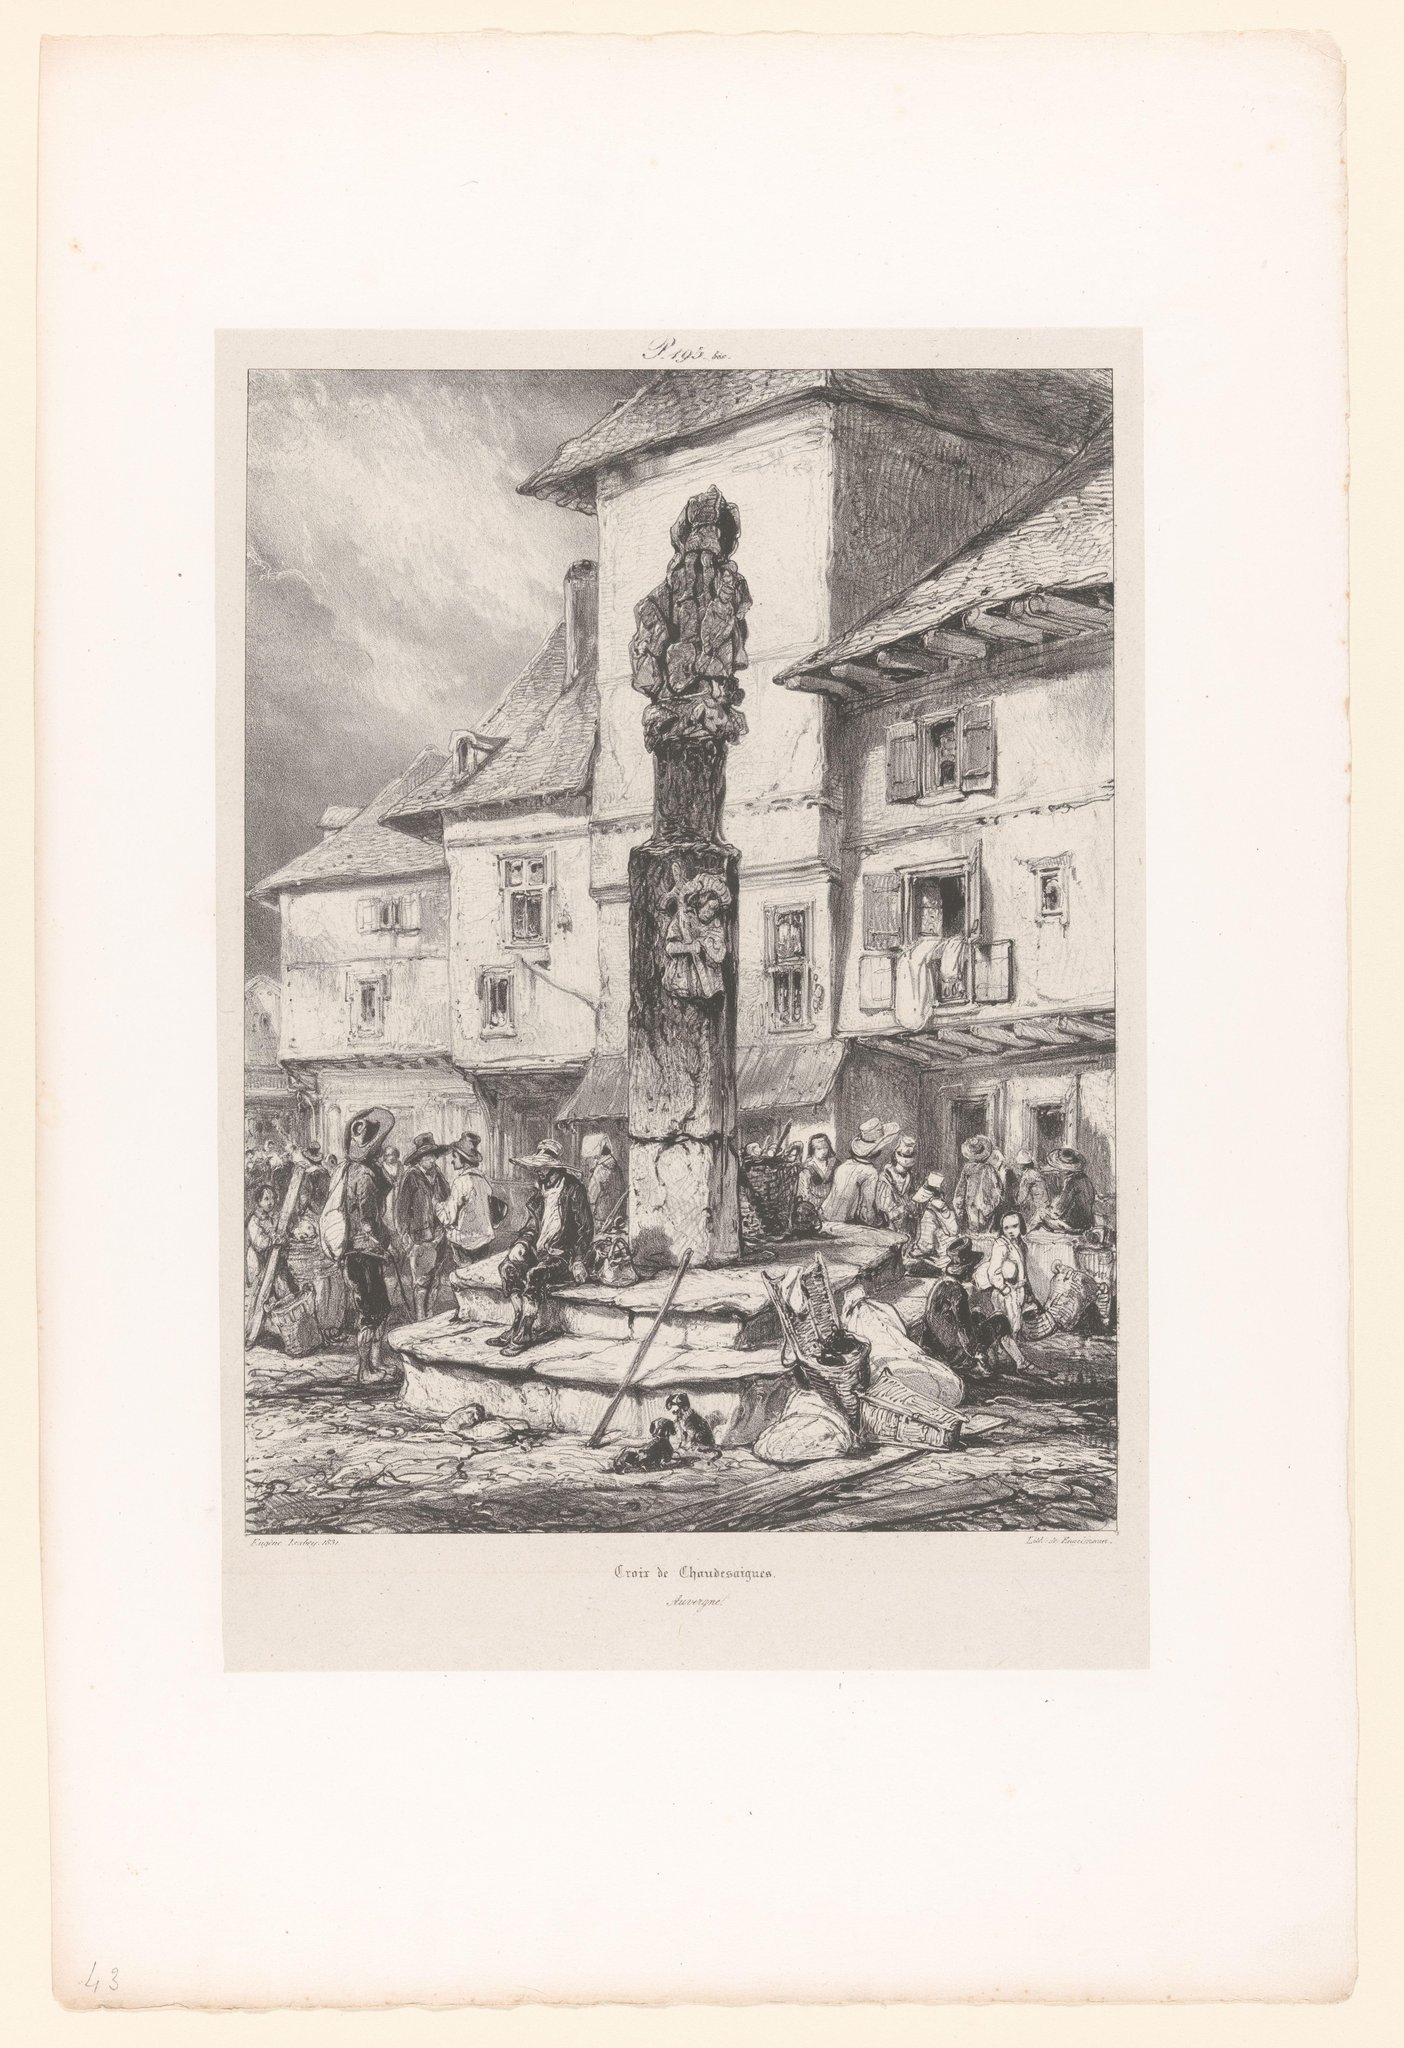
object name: print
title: Croix de Chaudesaigues, Auvergne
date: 1831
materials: paper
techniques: lithograph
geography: paris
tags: monument, statue (+ city(-scape) with figures, staffage), village square, place (+ city(-scape) with figures, staffage)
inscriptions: collector's mark: Lugt 2760, collector's mark: Lugt 2228a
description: Prent gebruikt voor: Nodier, Ch. en Taylor, I. Voyages pittoresques et romantiques dans l'ancienne France. Auvergne. Parijs: Casimir Gide, 1829-1833. dl. 1, p. 195 bis.